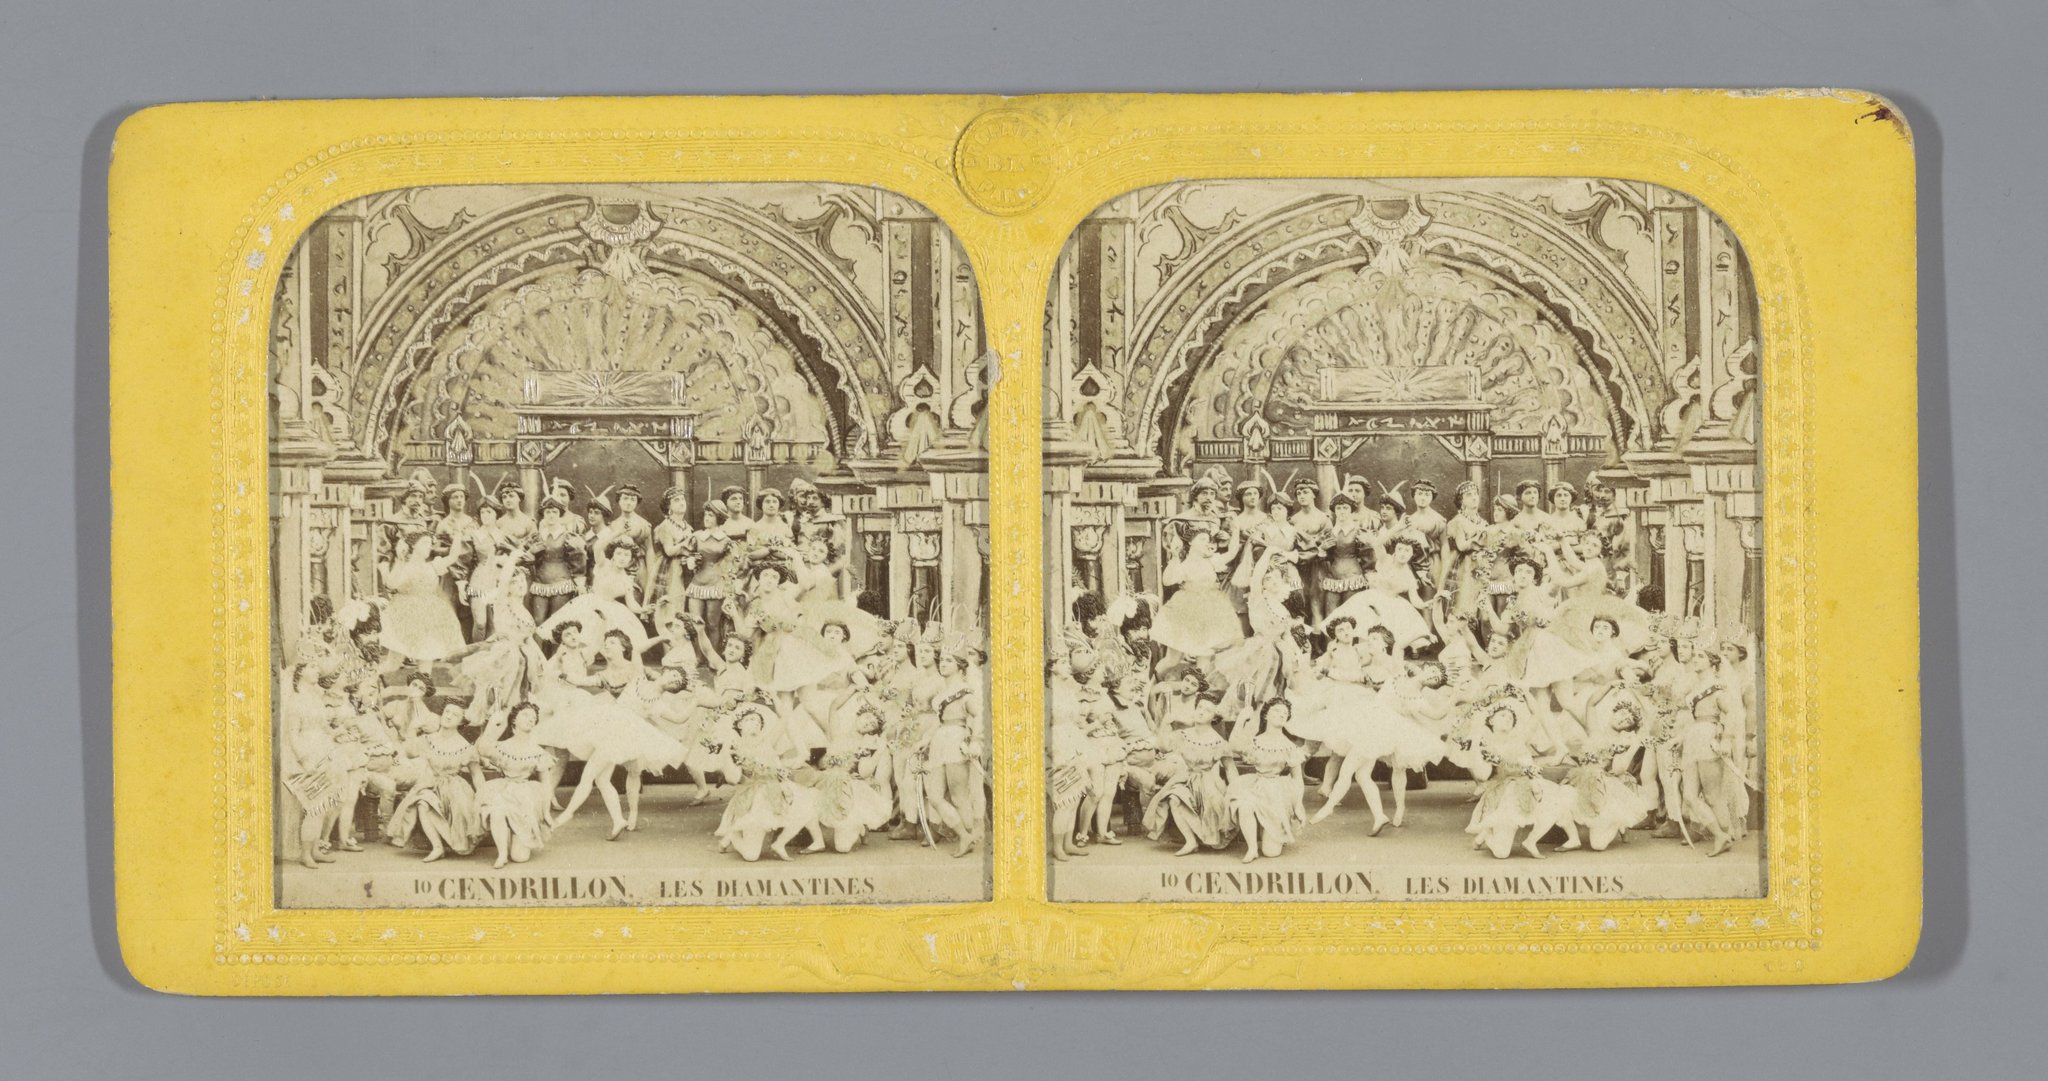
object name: tissue stereograph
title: Scène uit Assepoester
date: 1867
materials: cardboard, paper, photographic support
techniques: albumen print, cutting, hand coloring, perforating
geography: paris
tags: the arts of the stage: ballet, theatre, musical drama, motion picture, paris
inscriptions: number: ‘10’, inscription: ‘Toutes les épreuves non revêtues du timbre ci-contre/ seront considérées comme contrefacon, le Dépôt/ ayant été fait en France selon la loi et à l' Etranger/ conformément aux conventions internationales./ PROPRIÉTÉ/ B.K./ PARIS’, inscription: ‘DÉPOSÉ’